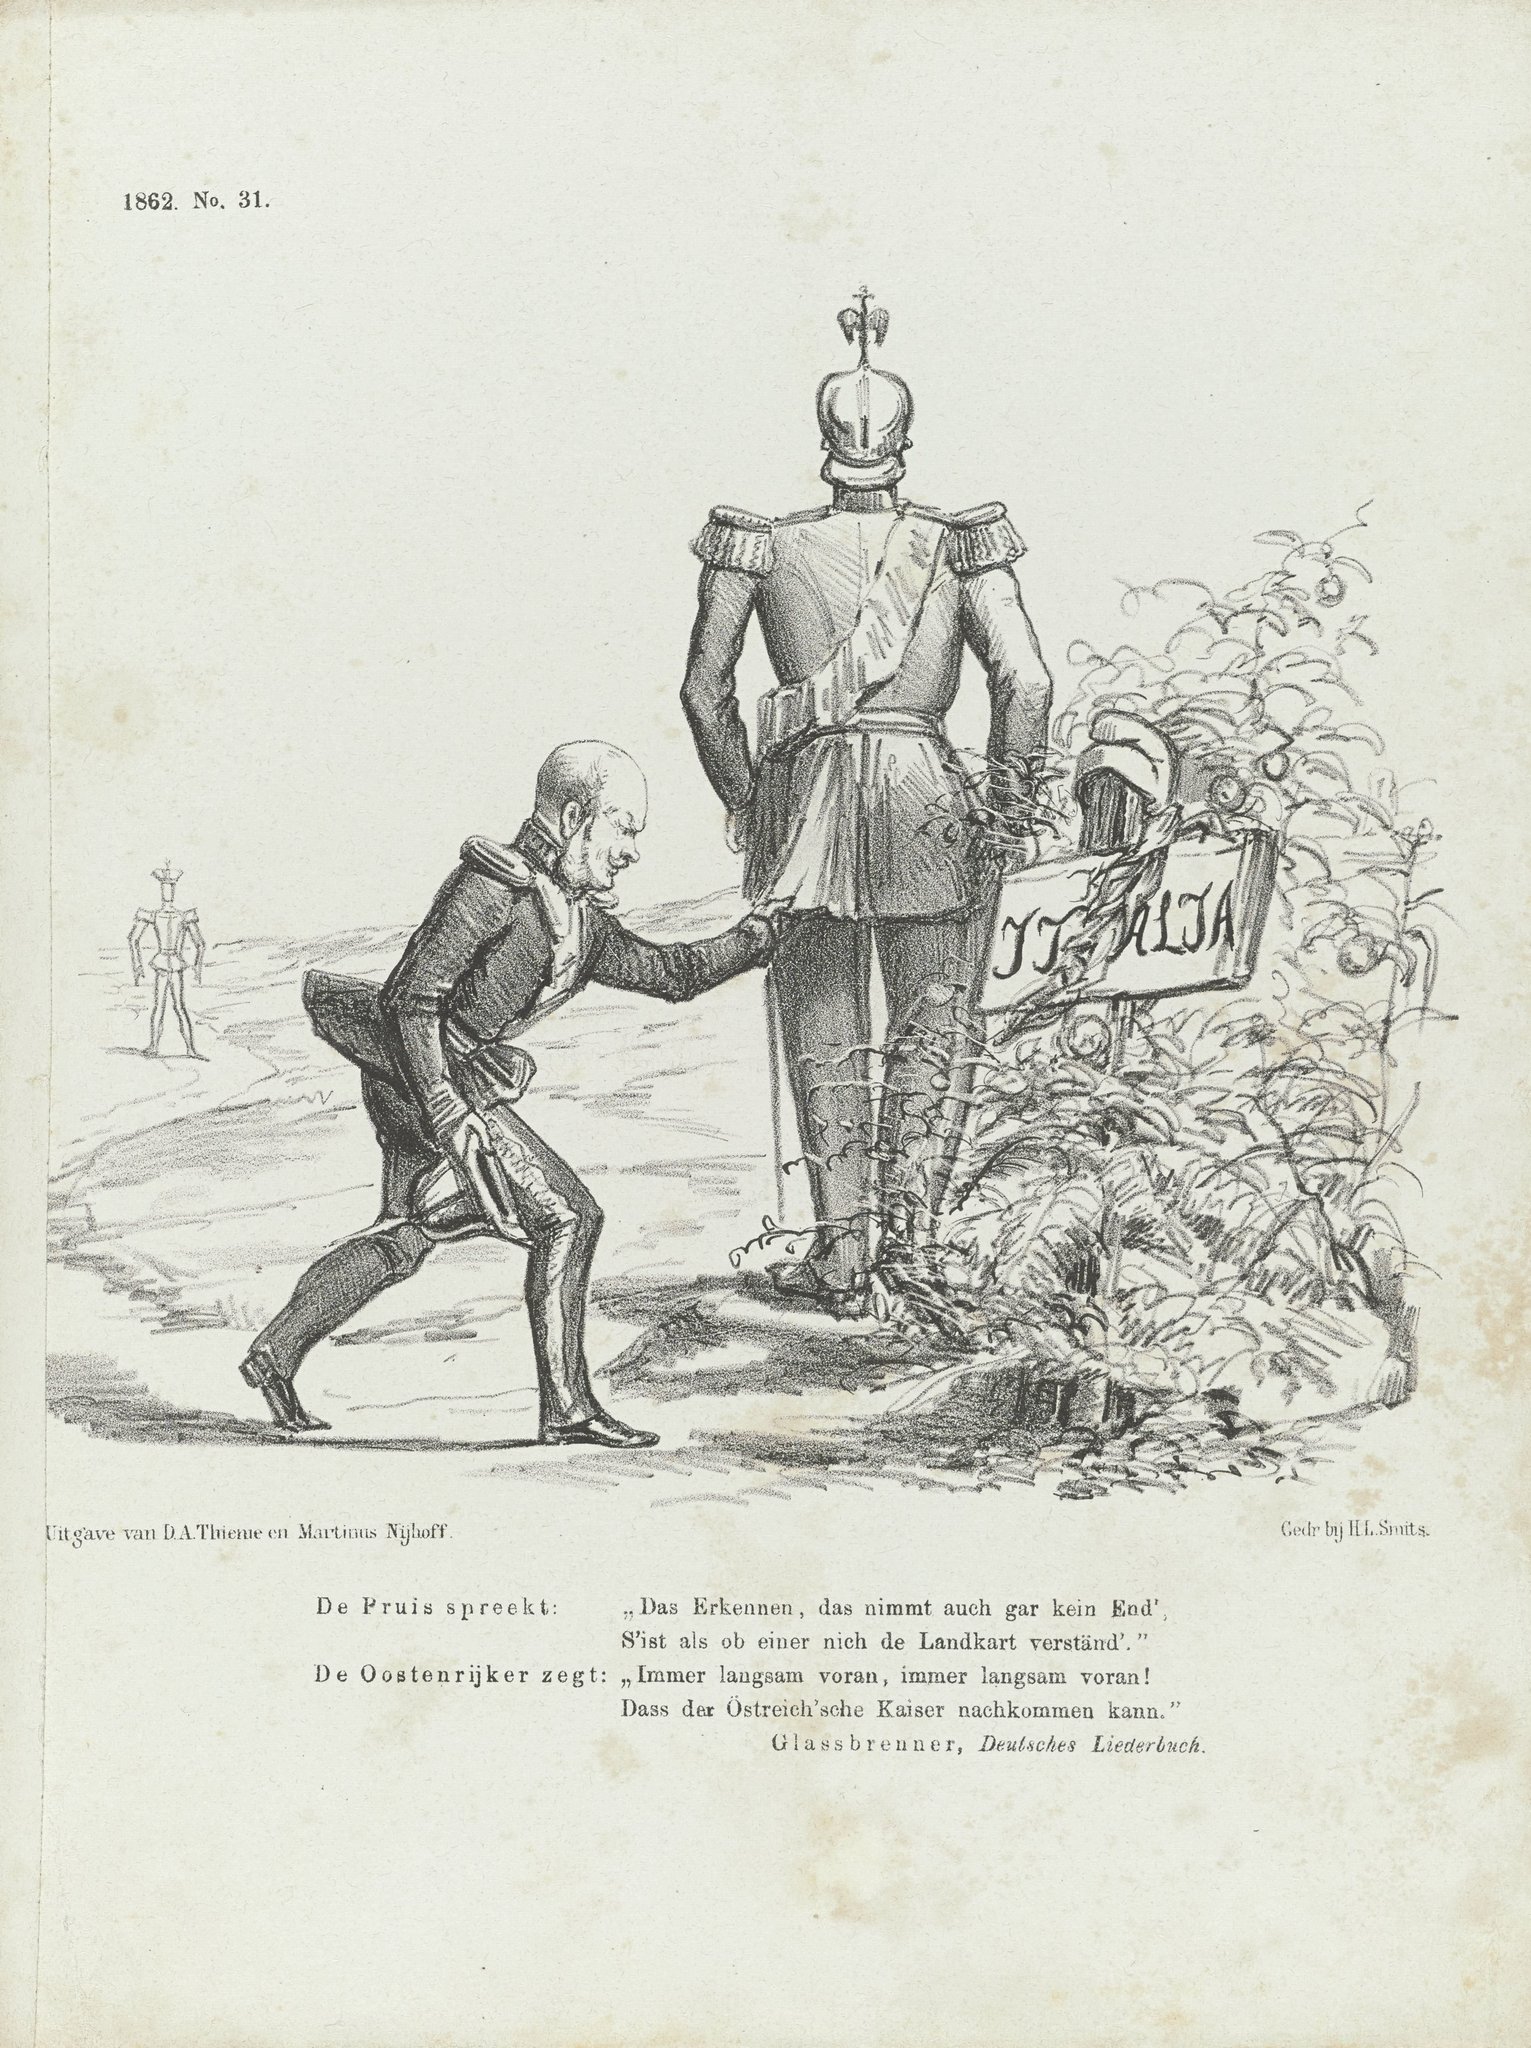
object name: cartoon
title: Spotprent over Italië, 1862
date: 1862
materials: paper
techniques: lithograph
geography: netherlands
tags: italy, austria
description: Spotprent met een Pruis en een Oostenrijker bij de grens met Italië. Plaat verschenen bij het weekblad De Nederlandsche Spectator, nr. 31, 2 augustus 1862.